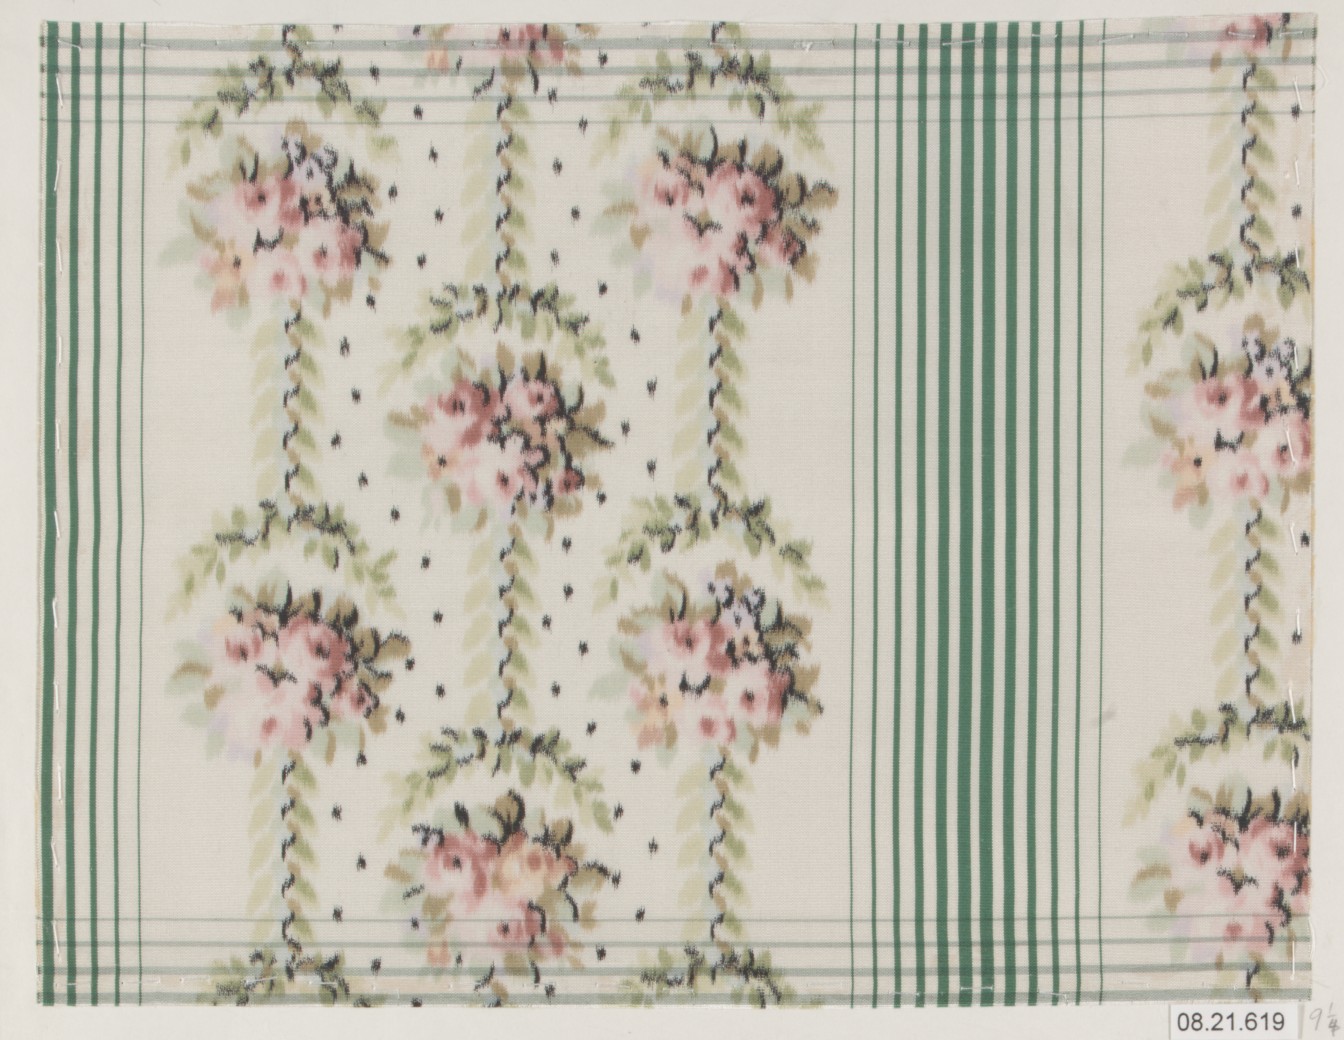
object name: textile sample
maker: Anonymous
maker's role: designer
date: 1900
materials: silk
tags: flowers